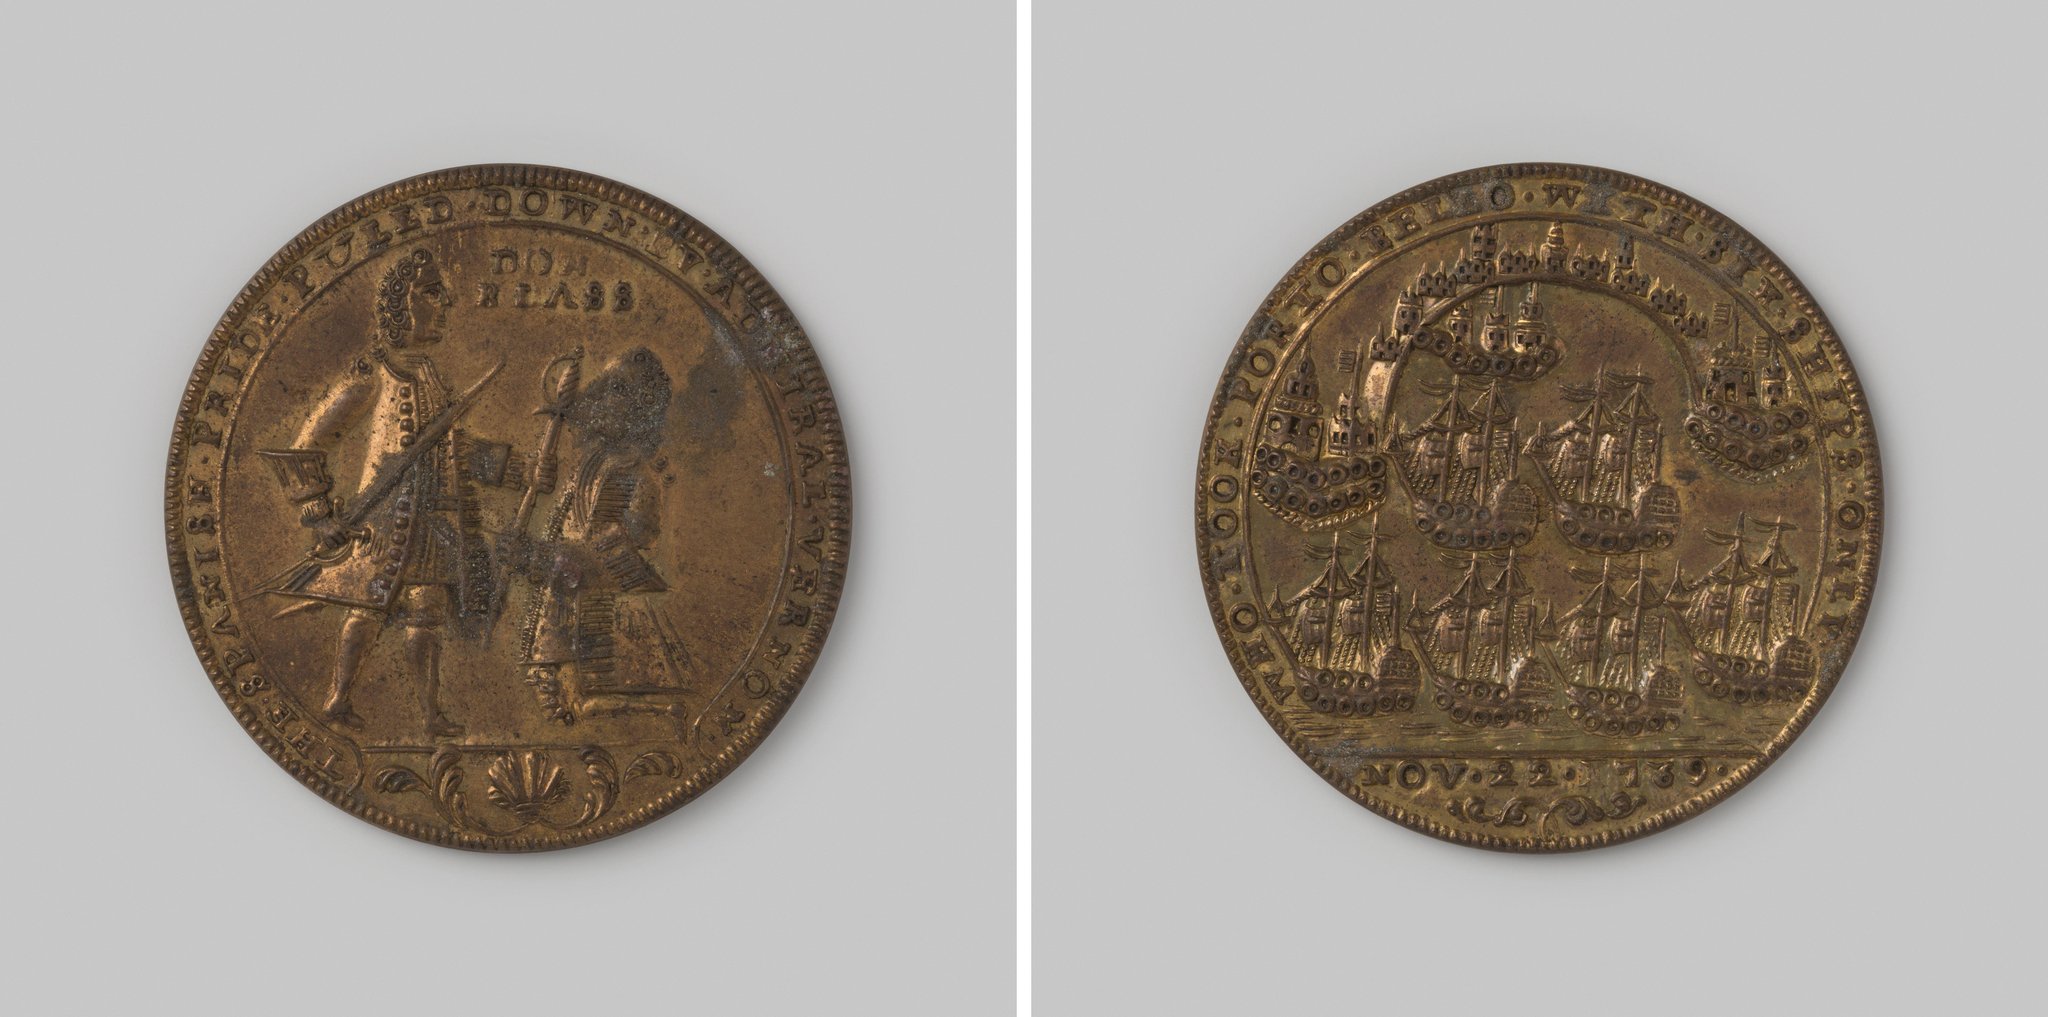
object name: history medal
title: Inname van Porto-Bello door Admiraal Vernon 1739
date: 1739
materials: brass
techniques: striking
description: Verguld messing penning, op de voorzijde Vernon staand naar rechts met zwaard, pakt het zwaard van de Spaanse verdediger Don Blas, met omschrift, op de keerzijde de haven van Porto Bello waarvoor zes schepen, met omschrift en afsnedetekst.